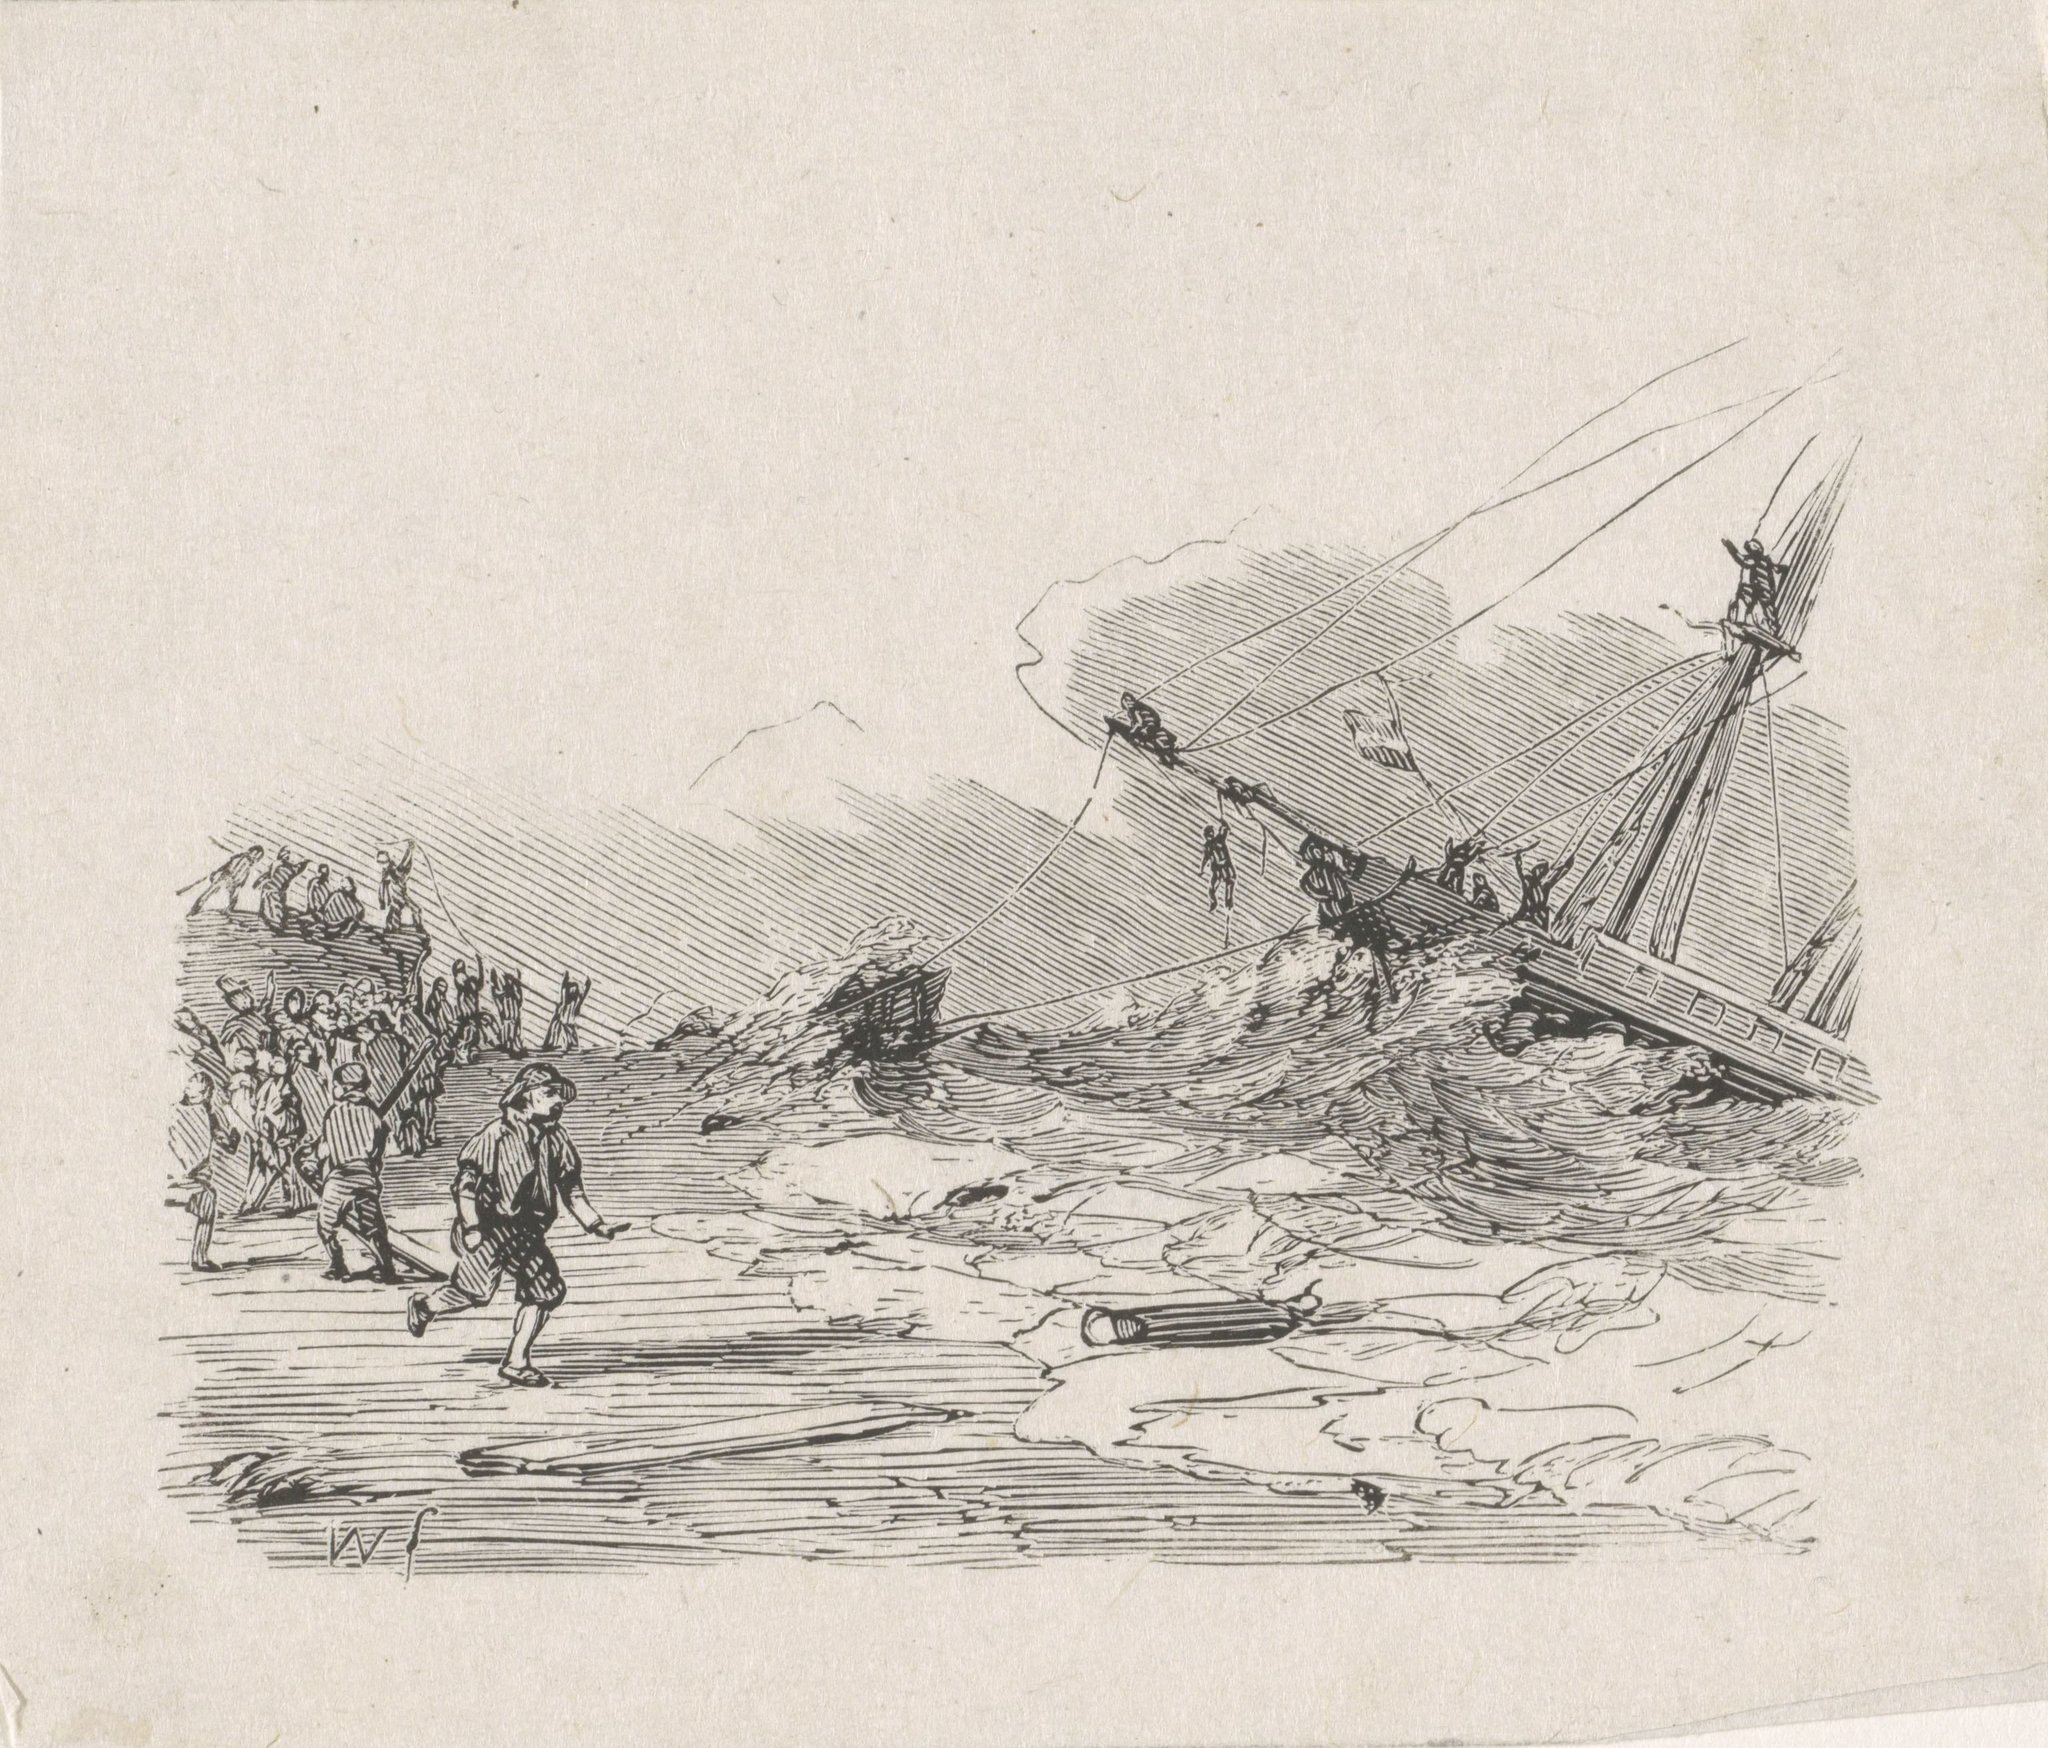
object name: print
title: Afschaffing van sterke dranken in 1838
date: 1838-1912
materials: paper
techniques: engraving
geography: netherlands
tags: sailing-ship, sailing-boat, alcoholic drinks, storm at sea